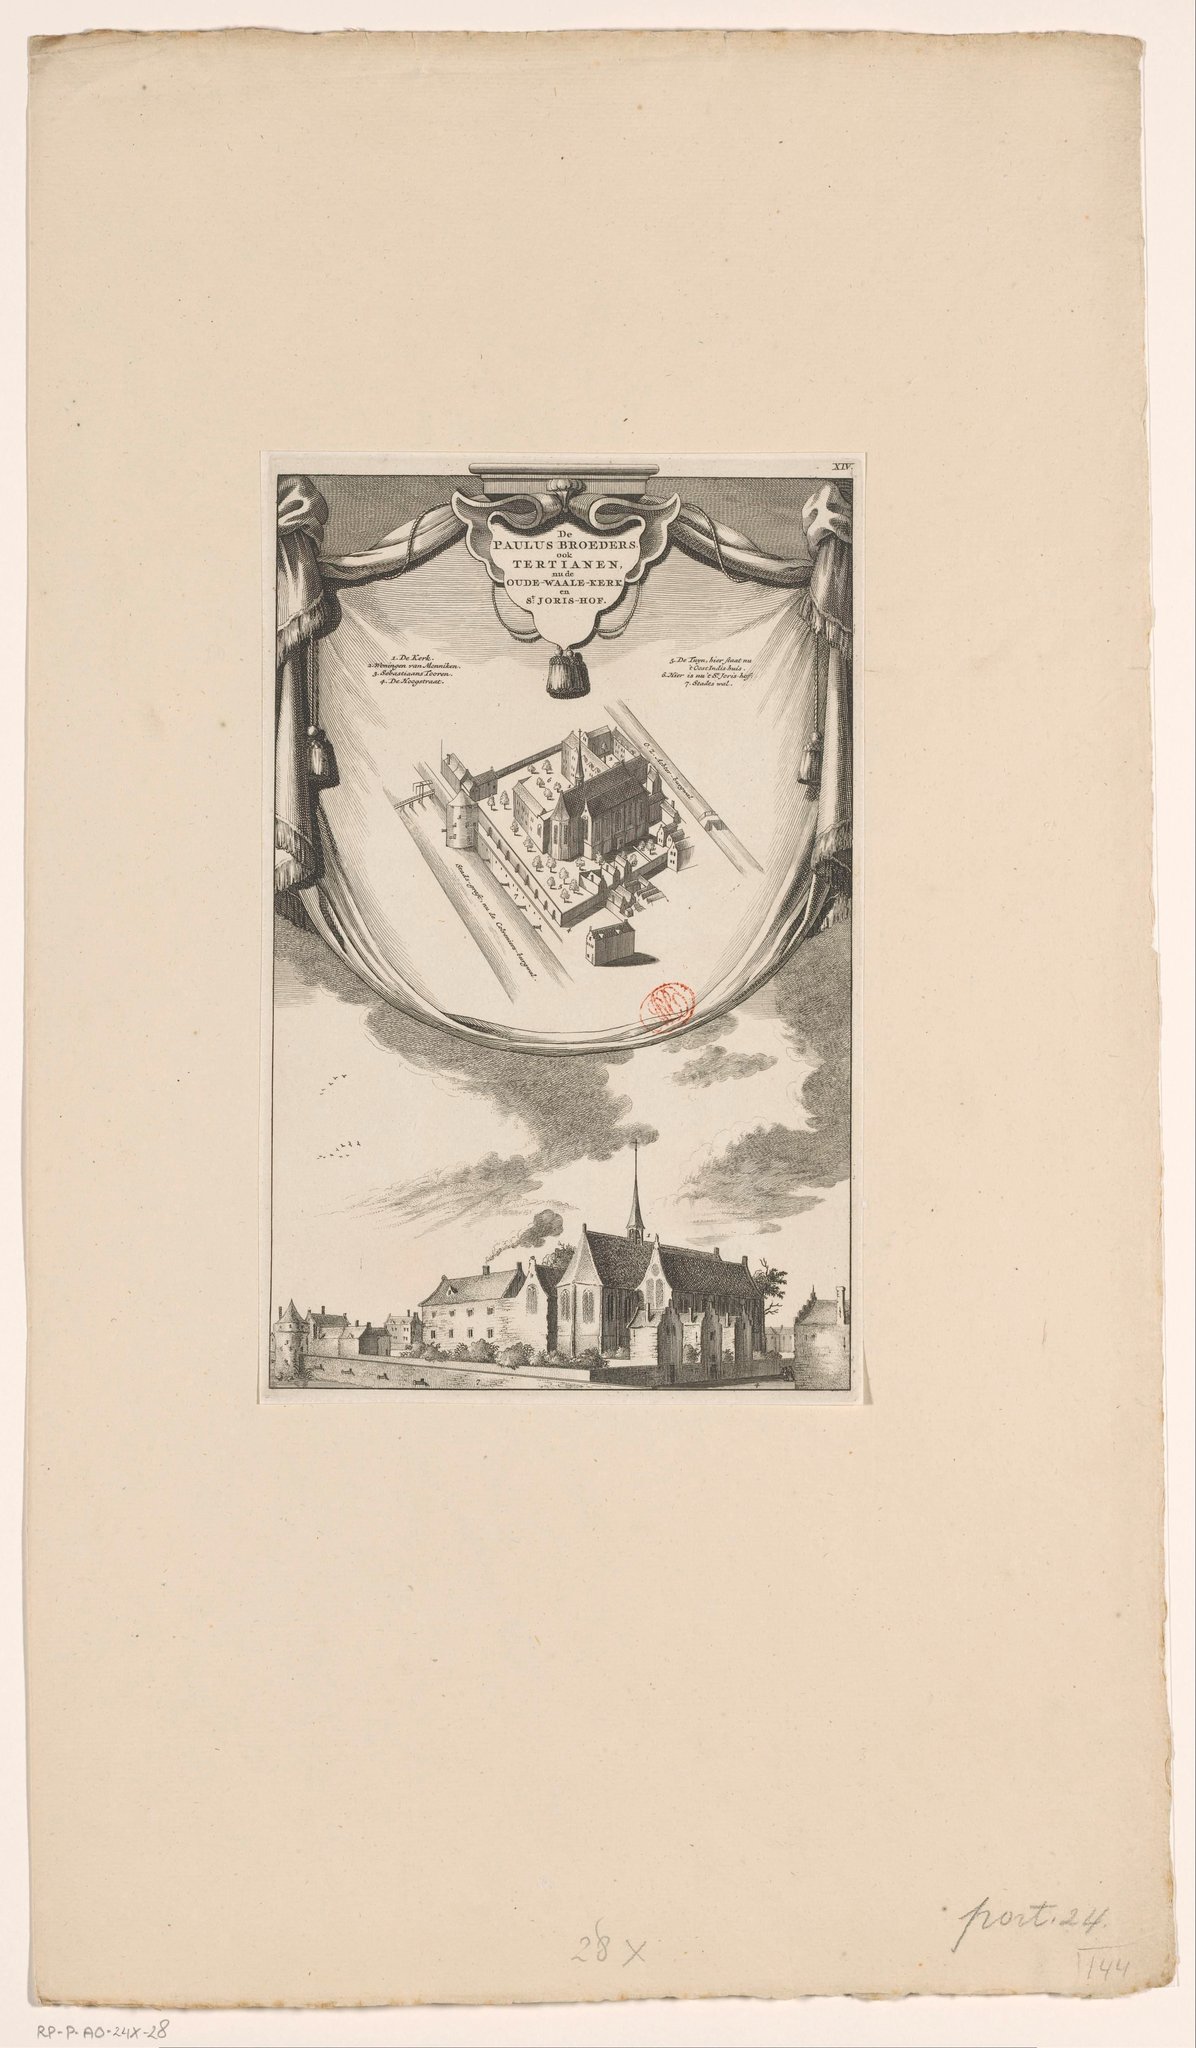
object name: book illustration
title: Gezichten op het Sint-Paulusbroedersklooster te Amsterdam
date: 1760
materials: paper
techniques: engraving, etching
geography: amsterdam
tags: abbey, monastery, convent ~ roman catholic church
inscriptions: collector's mark: Lugt 2233, collector's mark: Lugt 195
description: Prent ook gebruikt in: Wagenaar, Jan. Amsterdam, in zyne opkomst, aanwas, geschiedenissen (…). 3 delen [folio-uitgave]. Amsterdam: Isaak Tirion en Yntema & Tieboel, 1760-1767, dl. 1 (Isaac Tirion, 1760). Zie RP-P-AO-24X-29 voor proefdruk. Dat de prent de situatie rond 1544 weergeeft gaat terug op het feit dat voor het maken van deze en andere prenten van kloosters en kerken van voor de Alteratie (1578) is uitgegaan van de plattegrond van Cornelis Anthonisz. uit 1544 (zie RP-P-OB-70.399 en RP-P-AO-20-15).